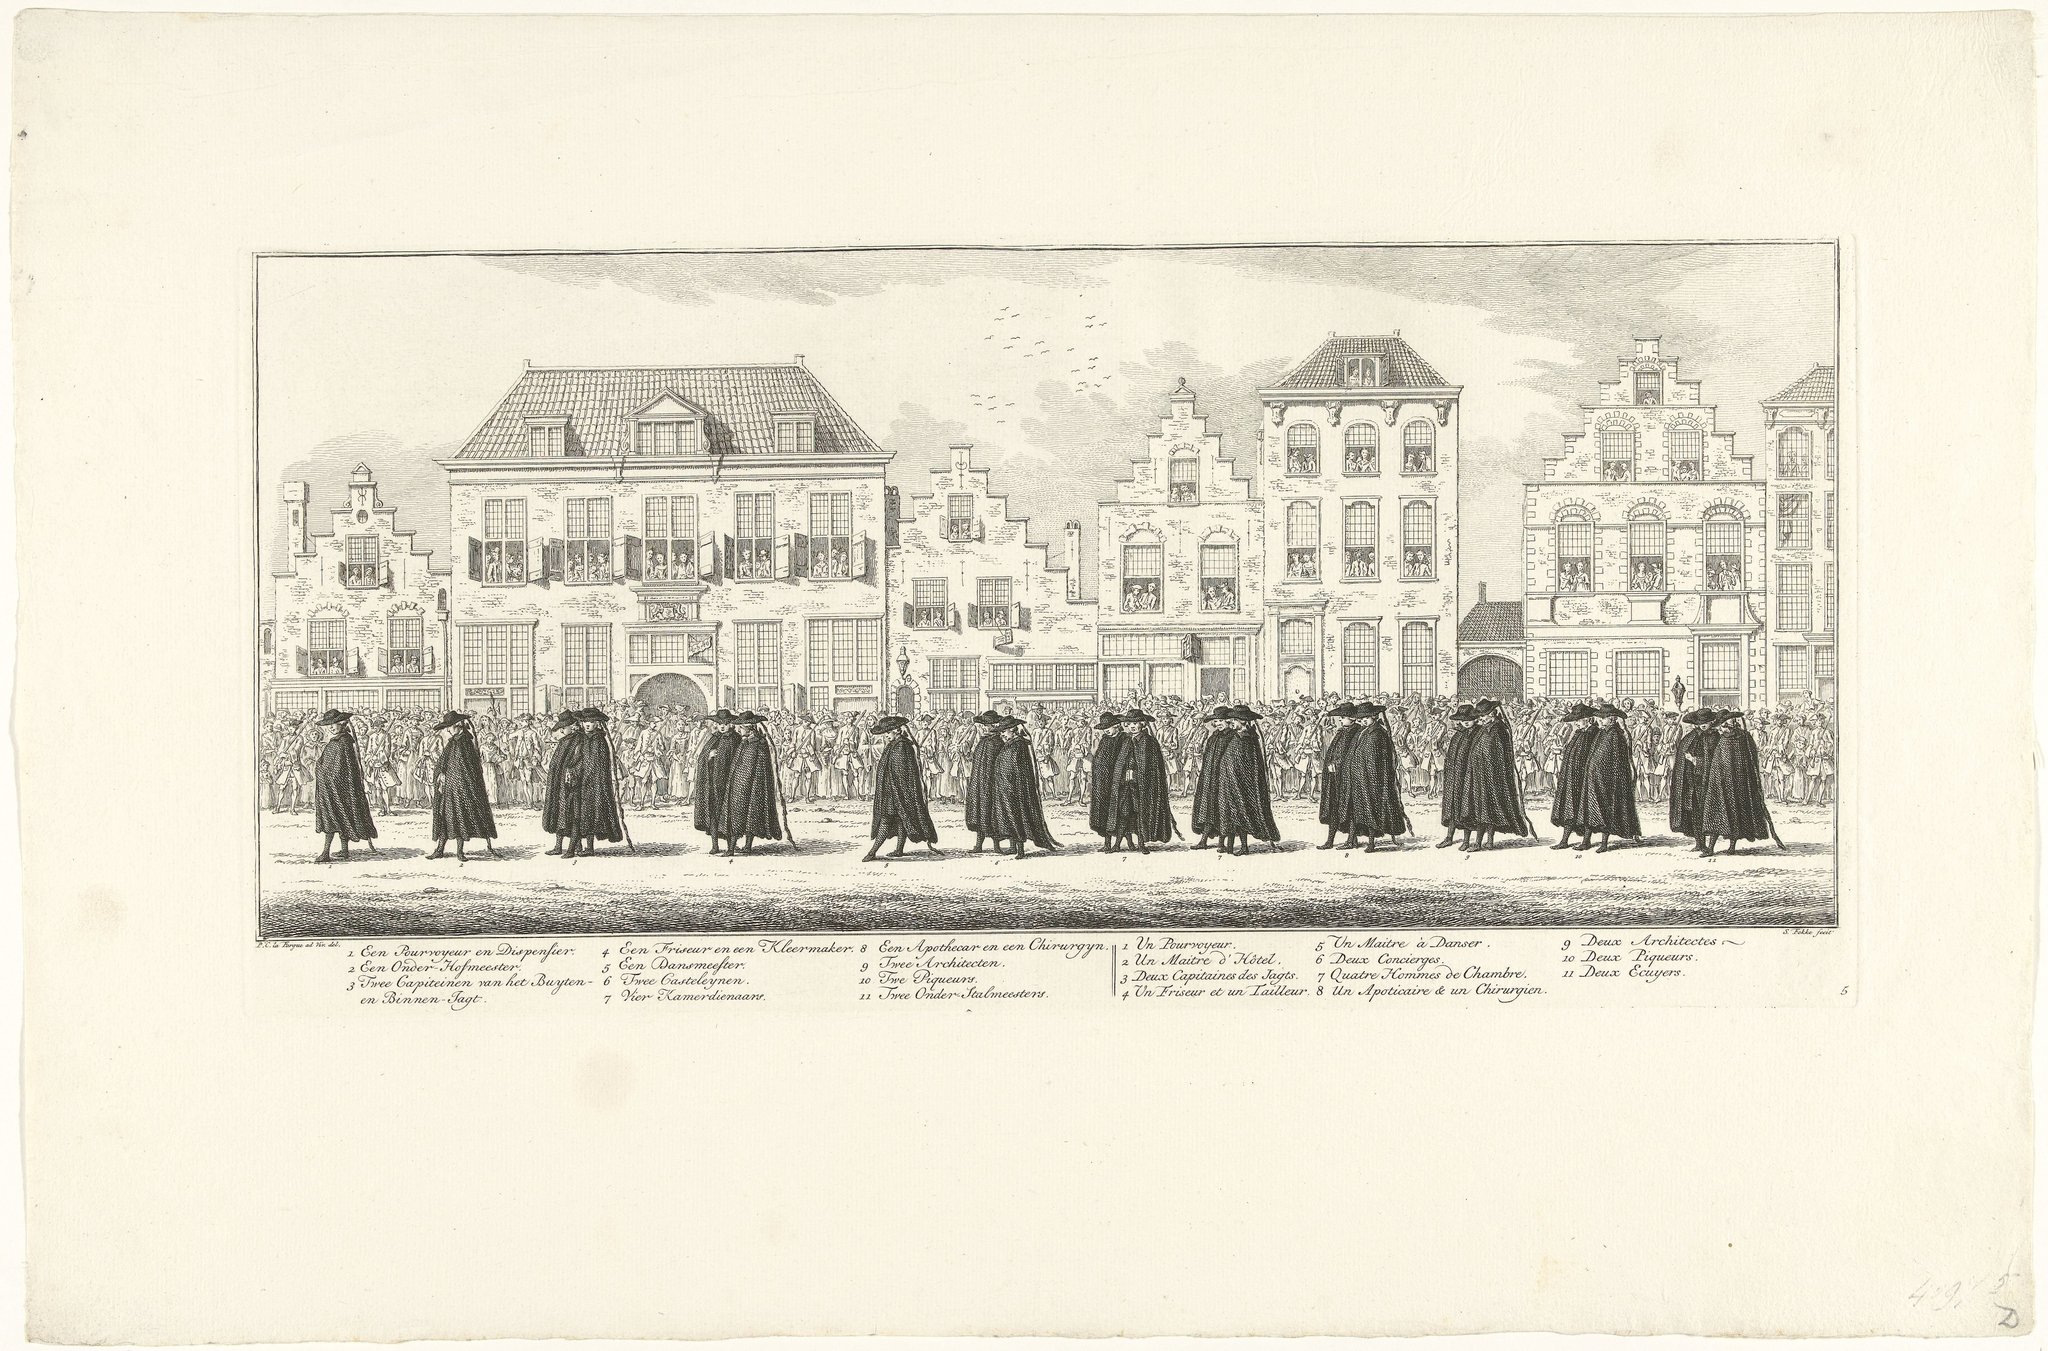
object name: print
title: Lijkstoet van prinses Anna van Hannover te Delft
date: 1759-1761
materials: paper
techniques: etching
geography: amsterdam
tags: the hague, anna van hannover, cortege, funeral procession, delft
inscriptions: collector's mark: Lugt 2228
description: Hofdienaren te voet in de lijkstoet van Anna van Hannover, prinses van Oranje-Nassau, te Delft. De figuren in de stoet zijn genummerd en onder de voorstelling nader omschreven.